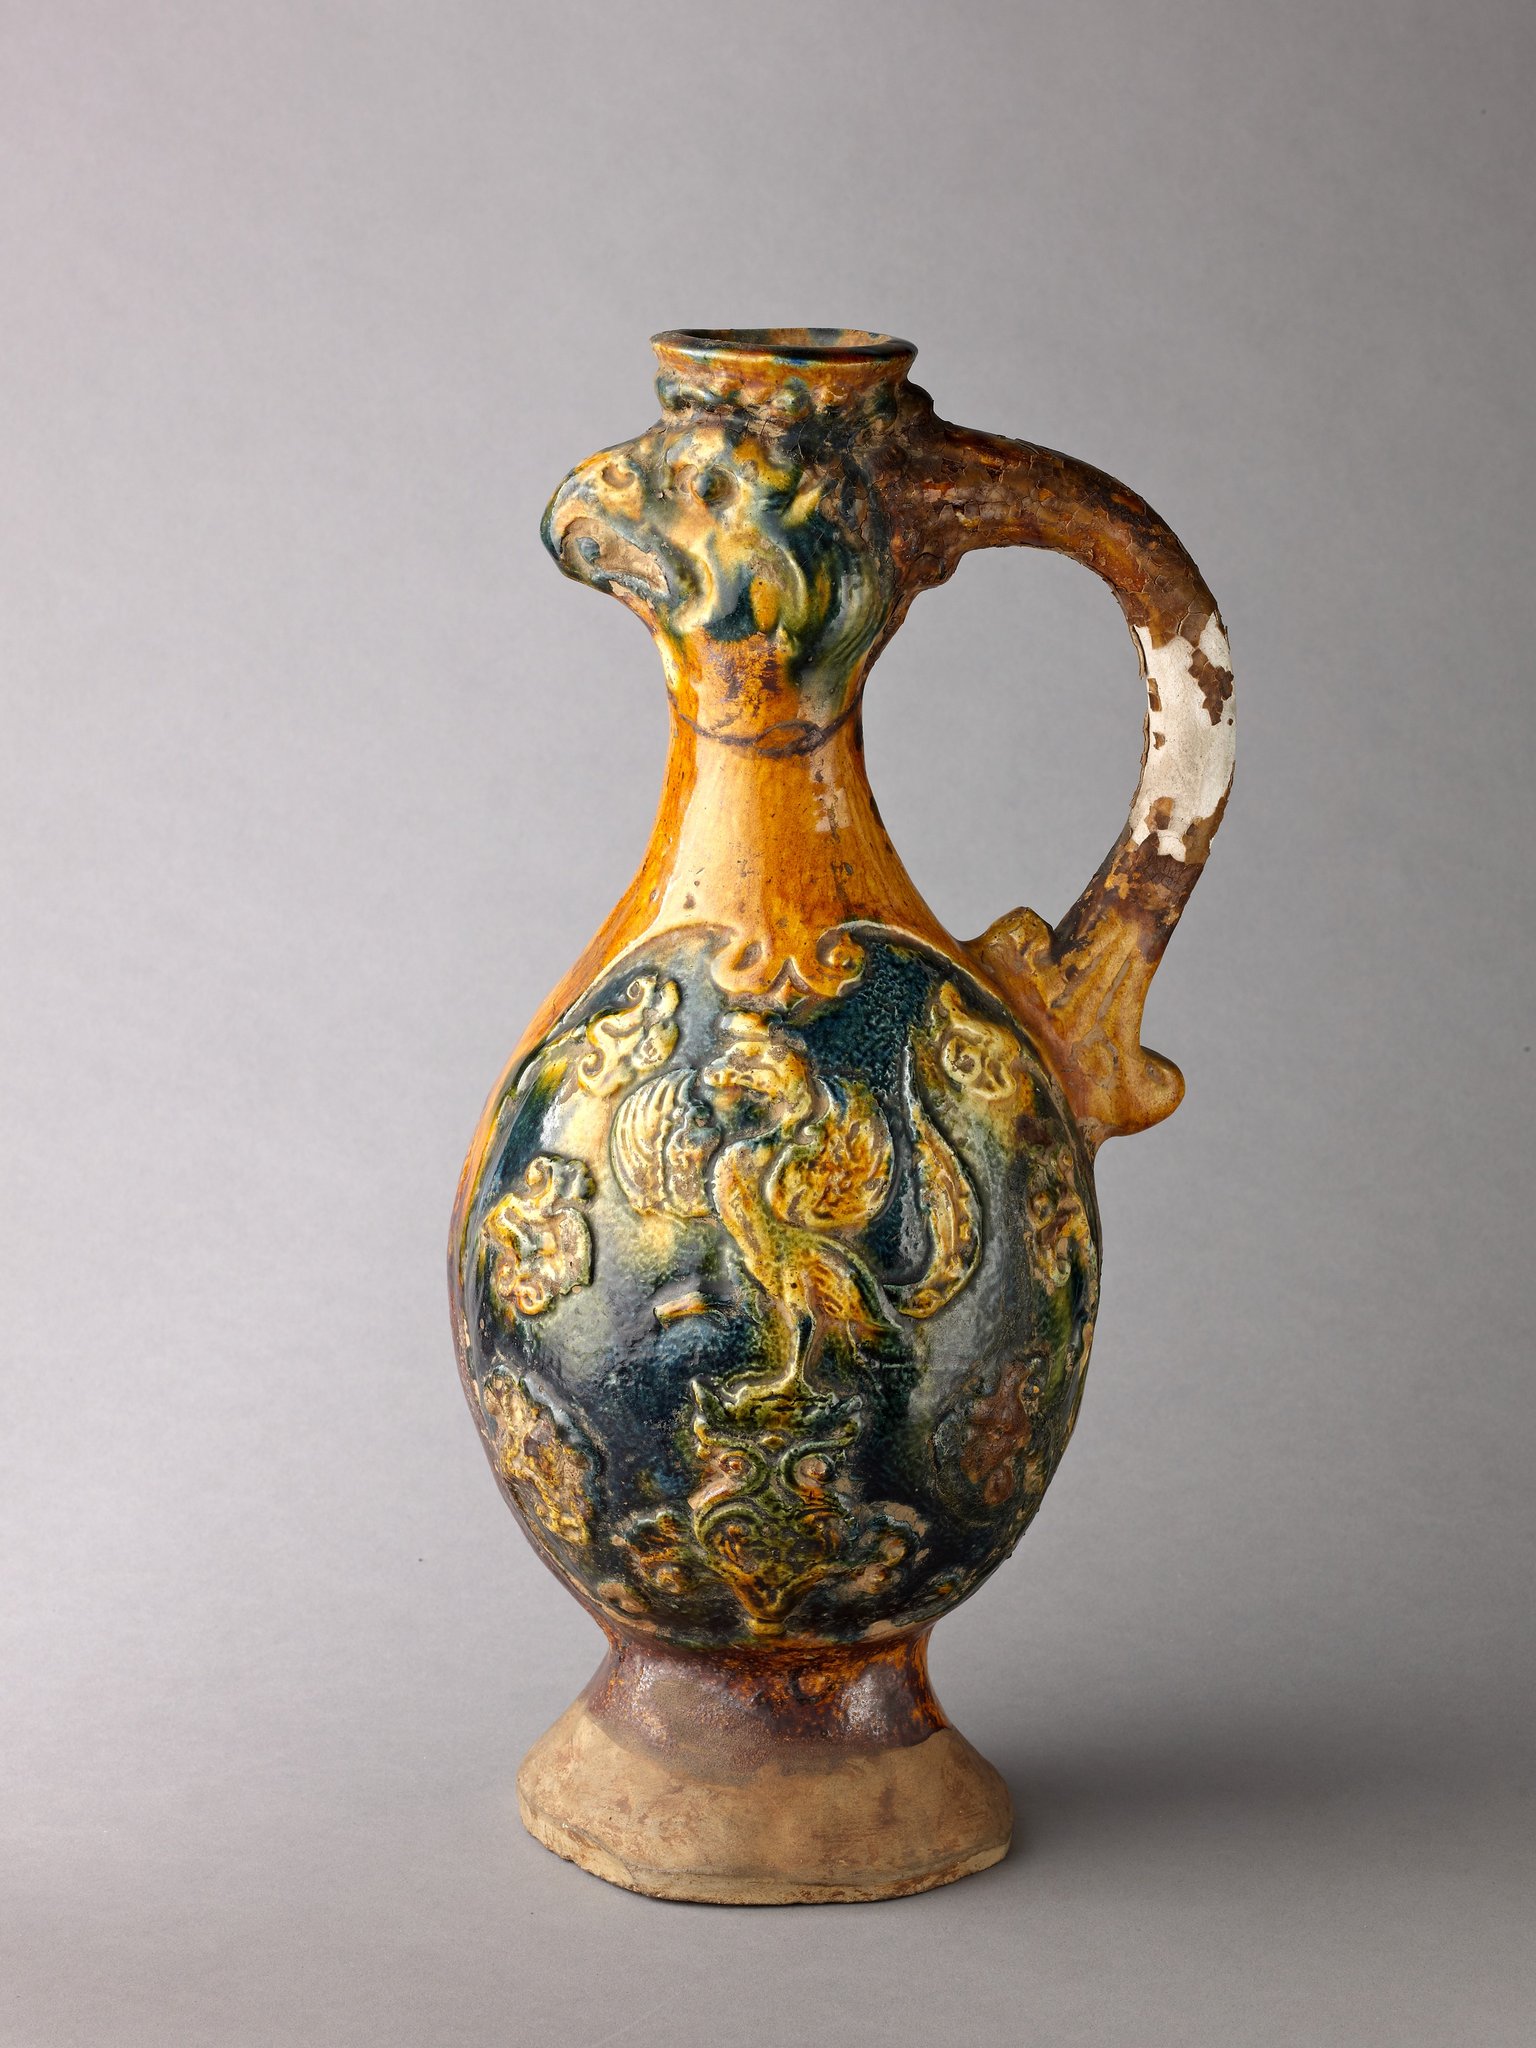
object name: ewer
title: Phoenix-head ewer, Tang sancai ware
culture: chinese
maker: chinese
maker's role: artist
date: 667-700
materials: earthenware, glaze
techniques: polychrome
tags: birds